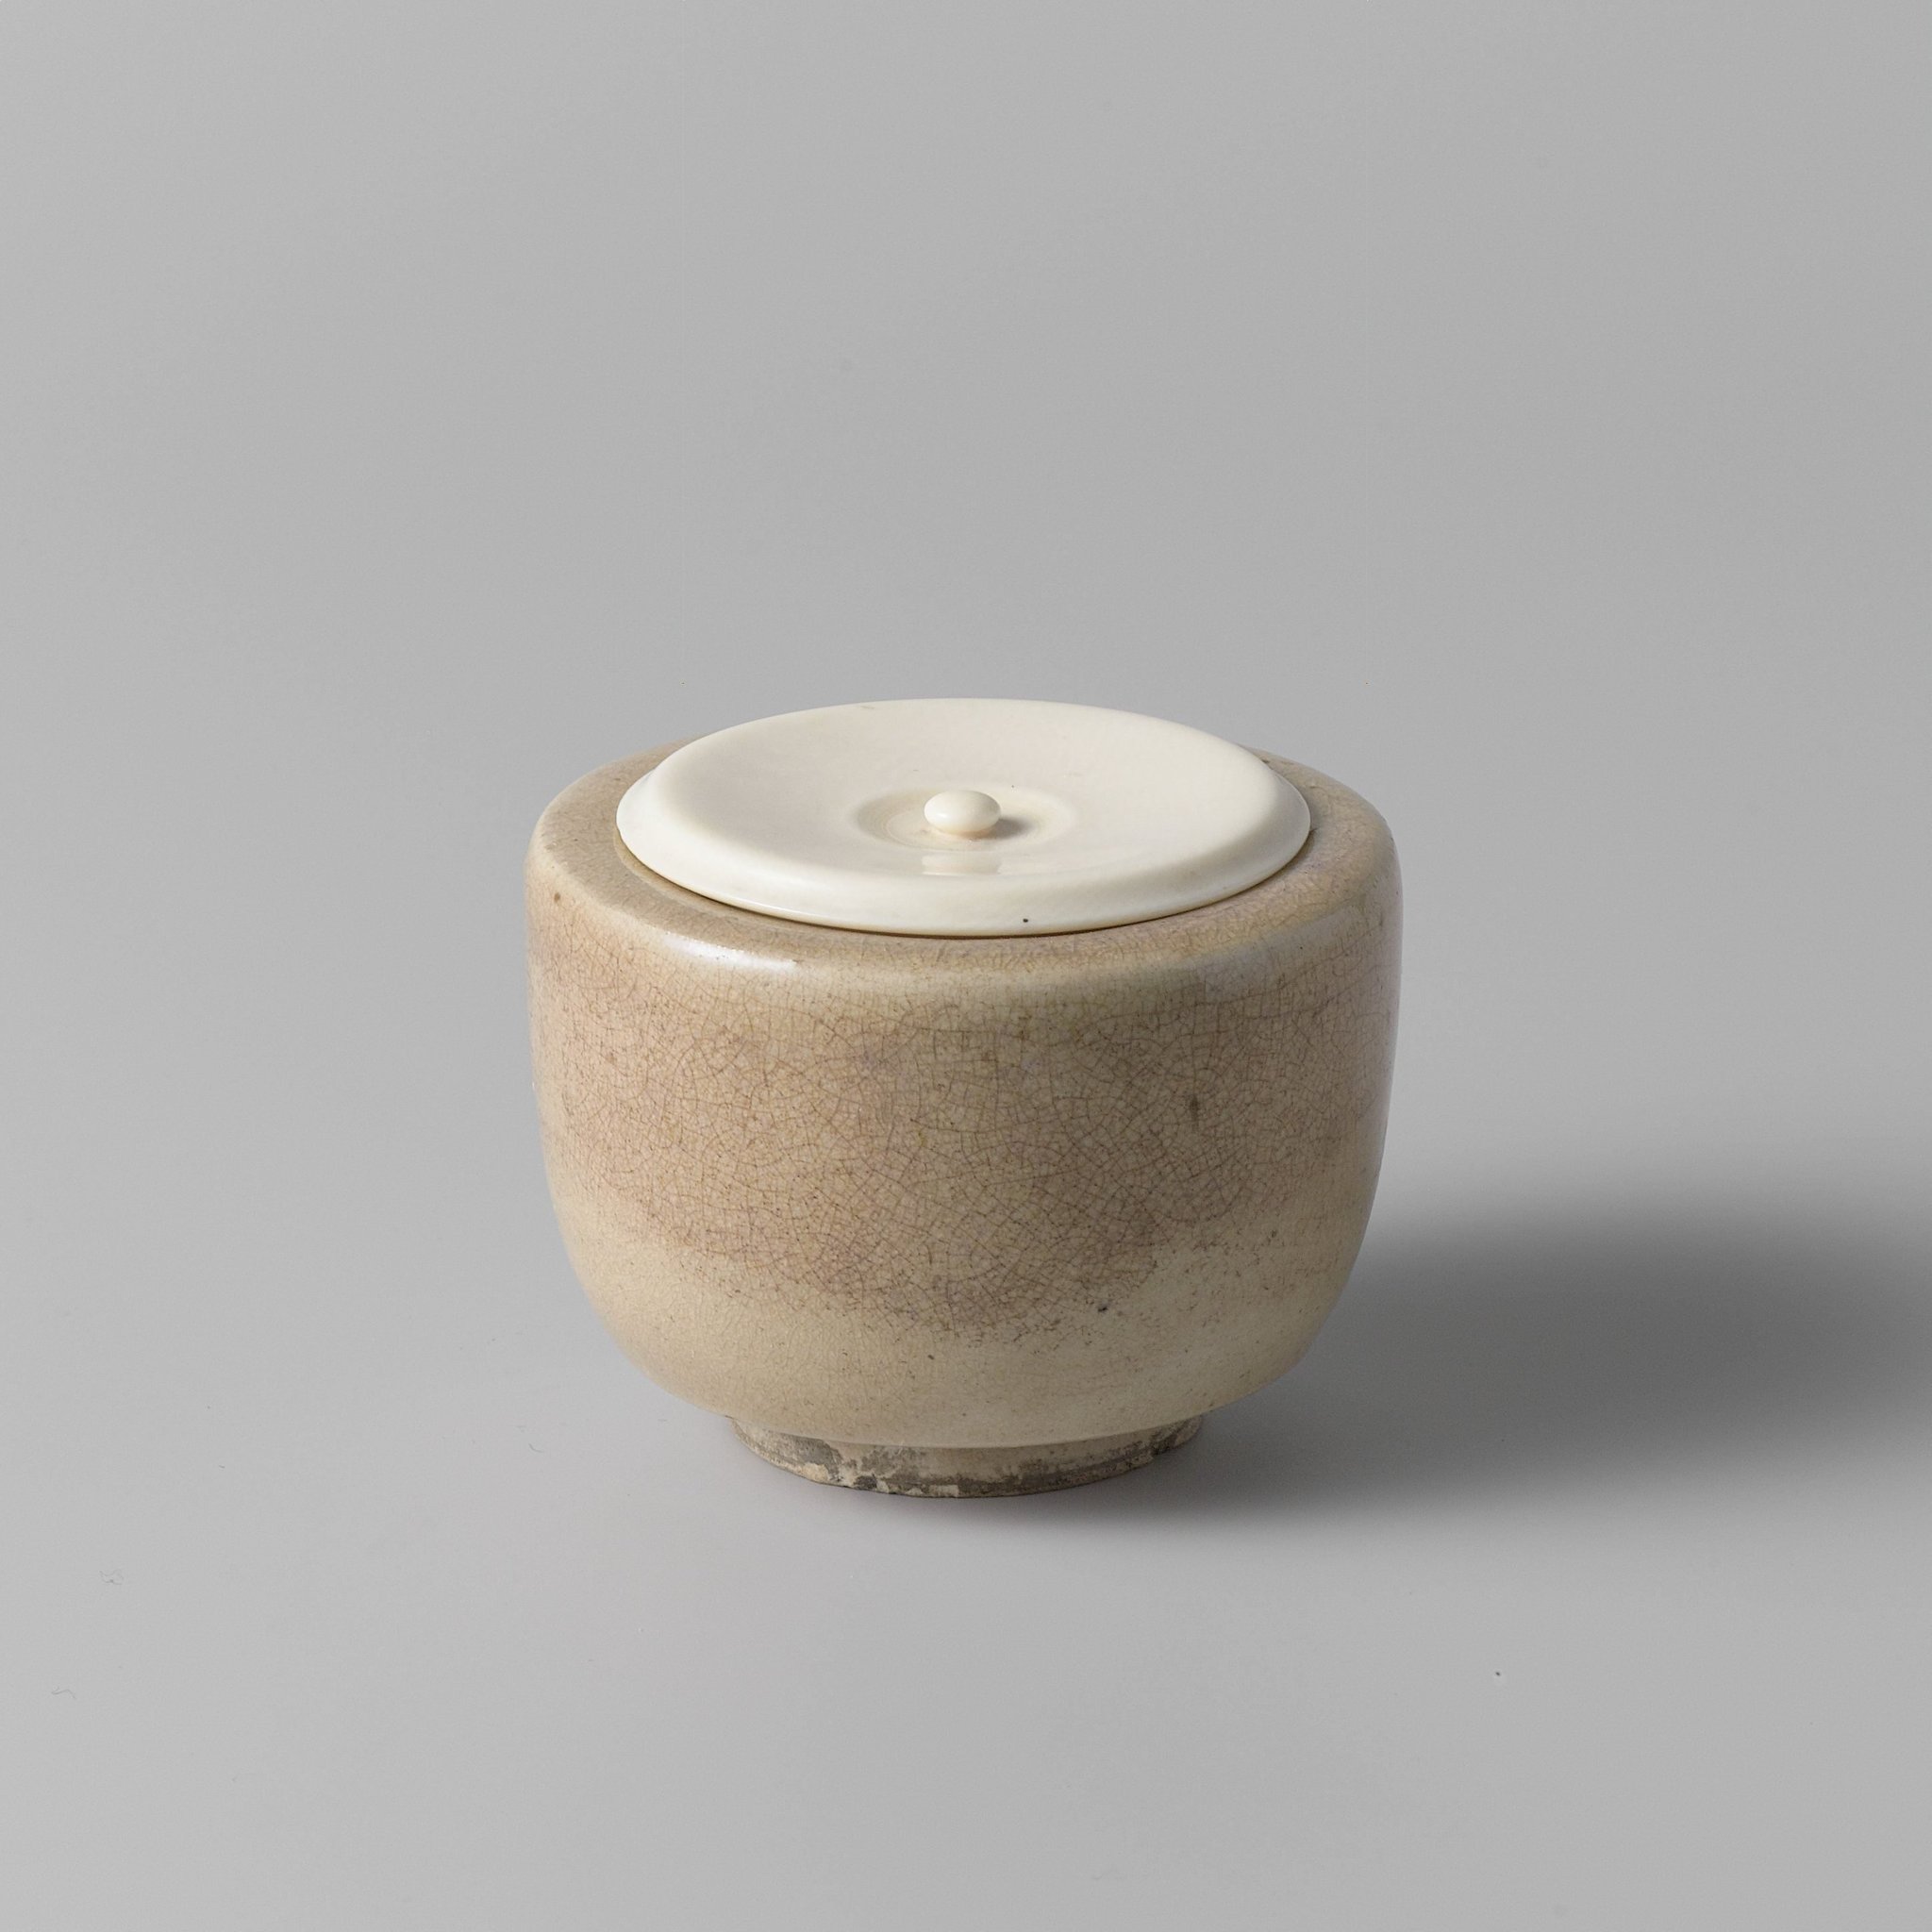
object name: tea caddy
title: Tea caddy met een wit slib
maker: Anonymous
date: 1800-1899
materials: glaze, ivory, paint, stoneware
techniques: firing, turning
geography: japan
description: Theebus van steengoed met een plat deksel van ivoor, bedekt met een wit slib.